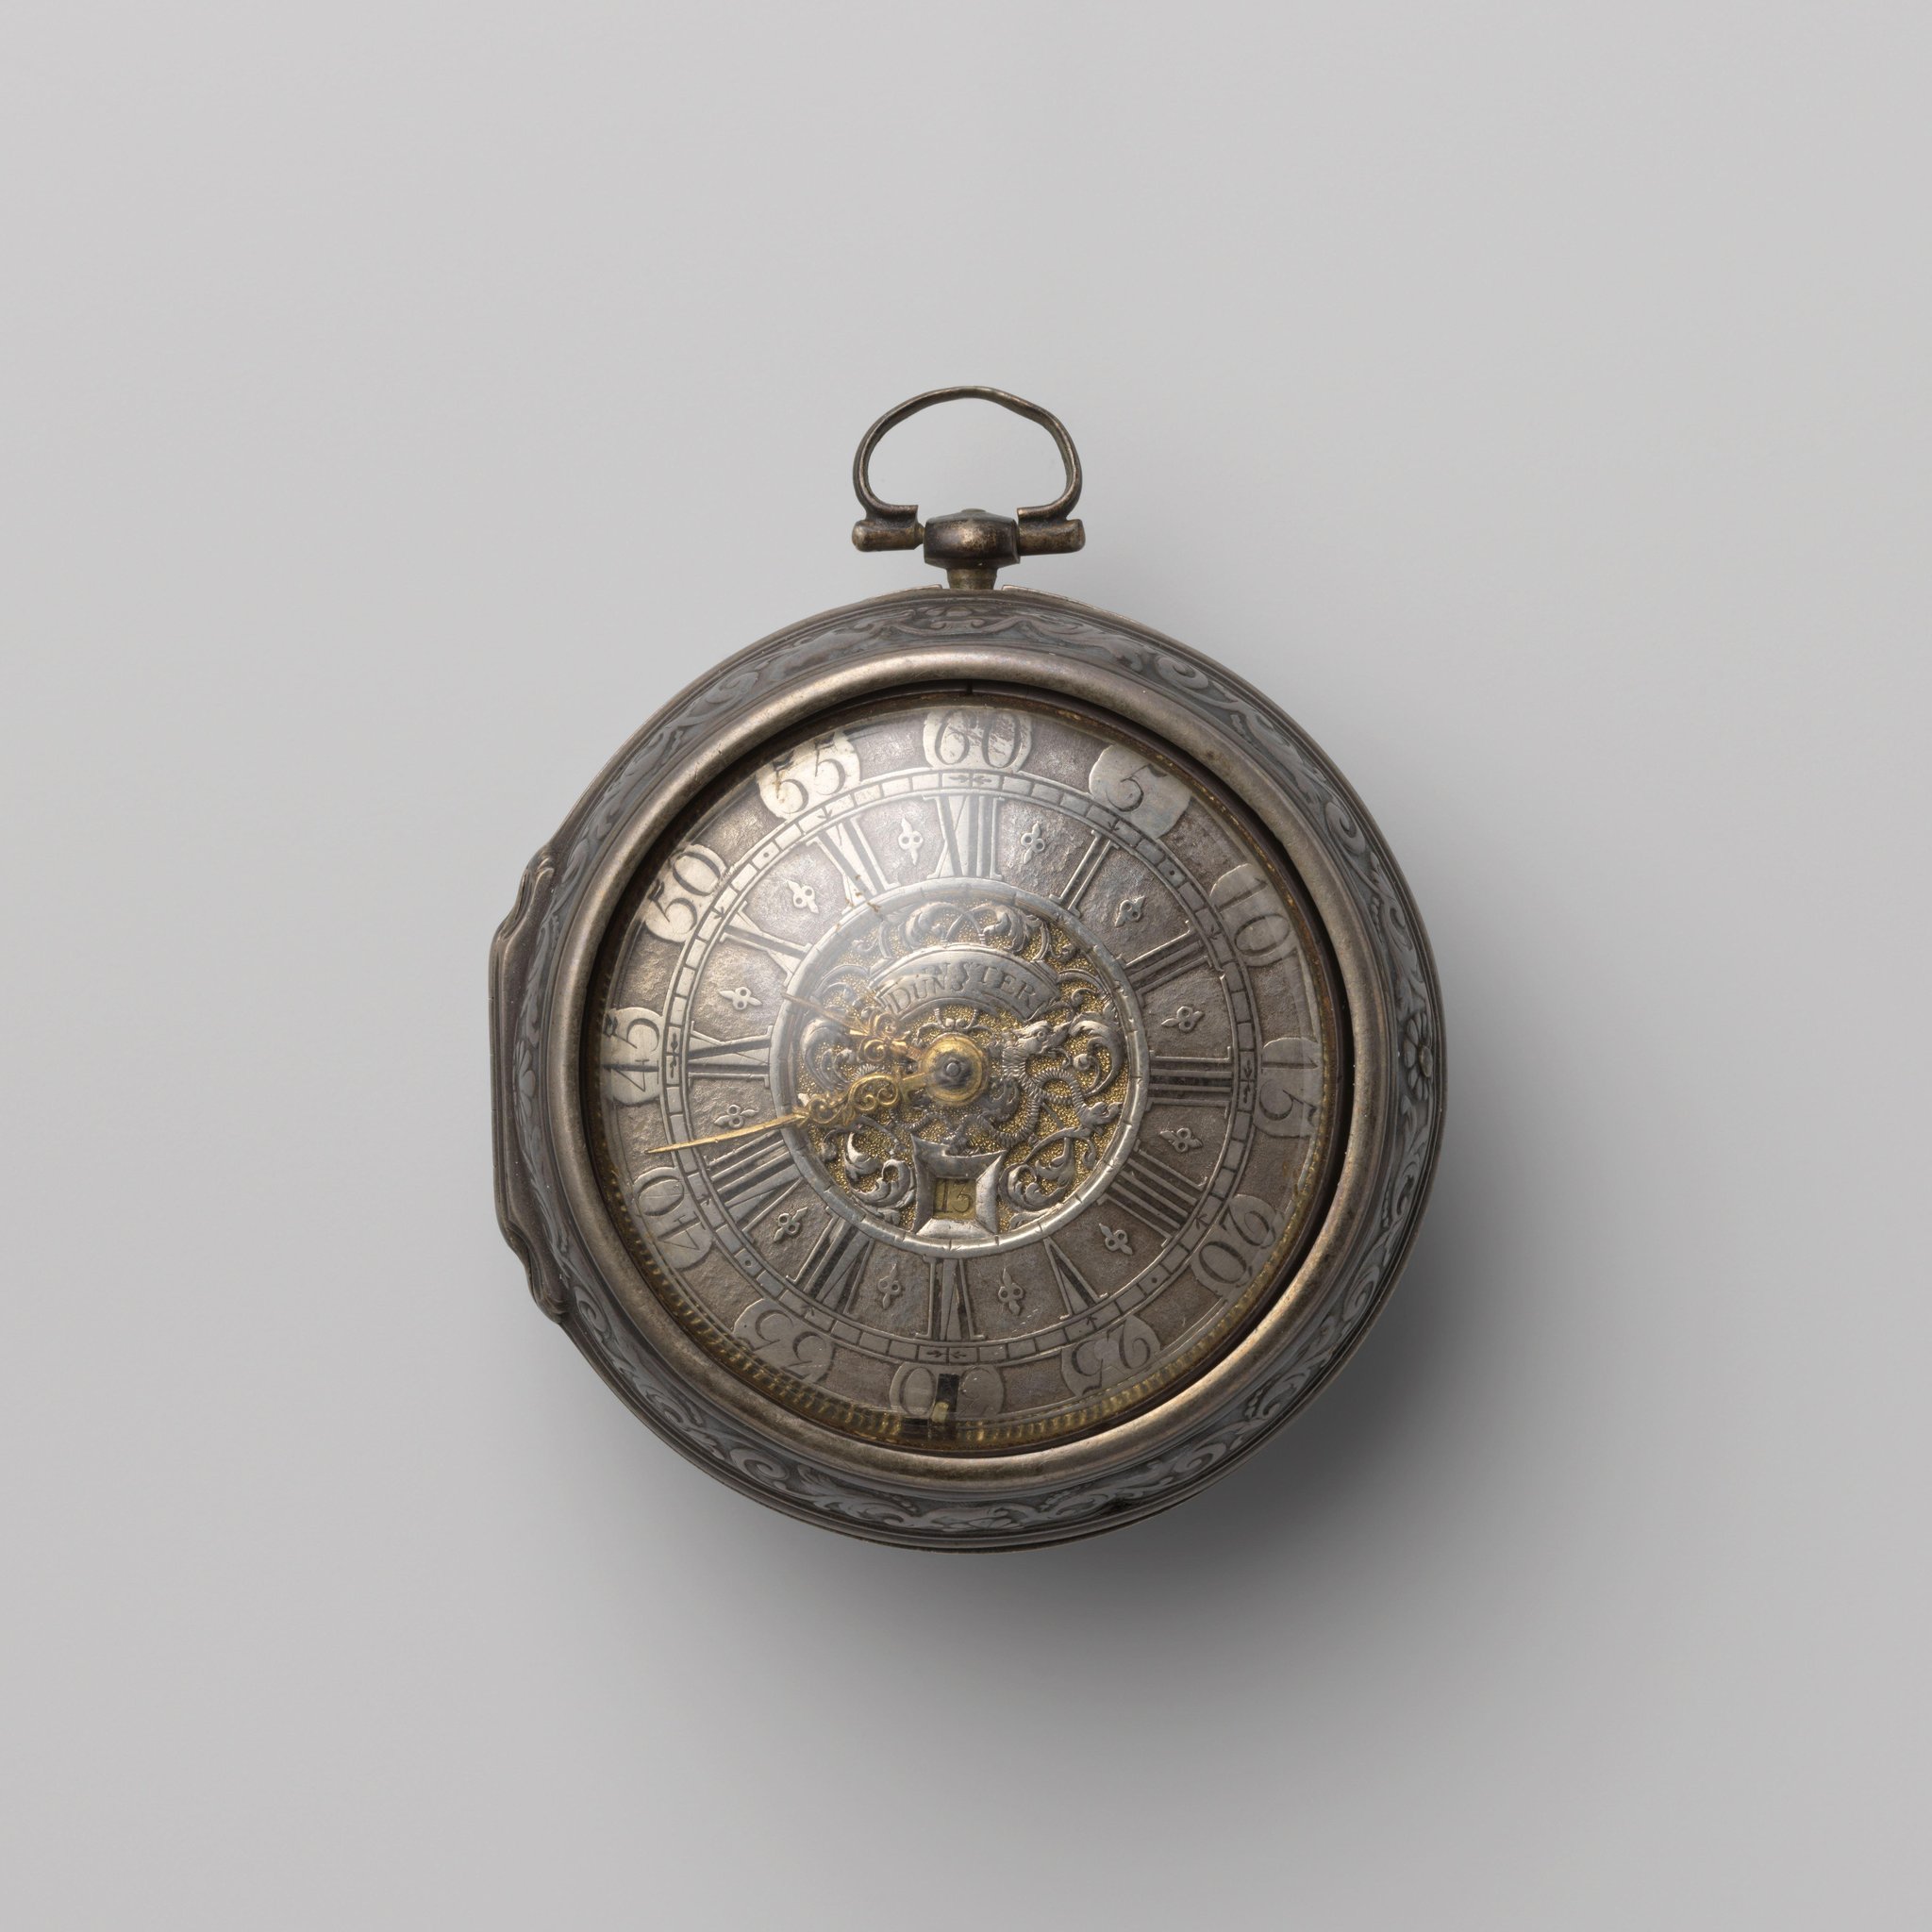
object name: jewellery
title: Horloge van zilver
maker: roger dunster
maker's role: horlogemaker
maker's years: -1747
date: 1700-1725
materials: silver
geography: great britain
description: Horloge van zilver met geciseleerde wijzerplaat met datumaanwijzing. In de buitenkast is een voorstelling gedreven.